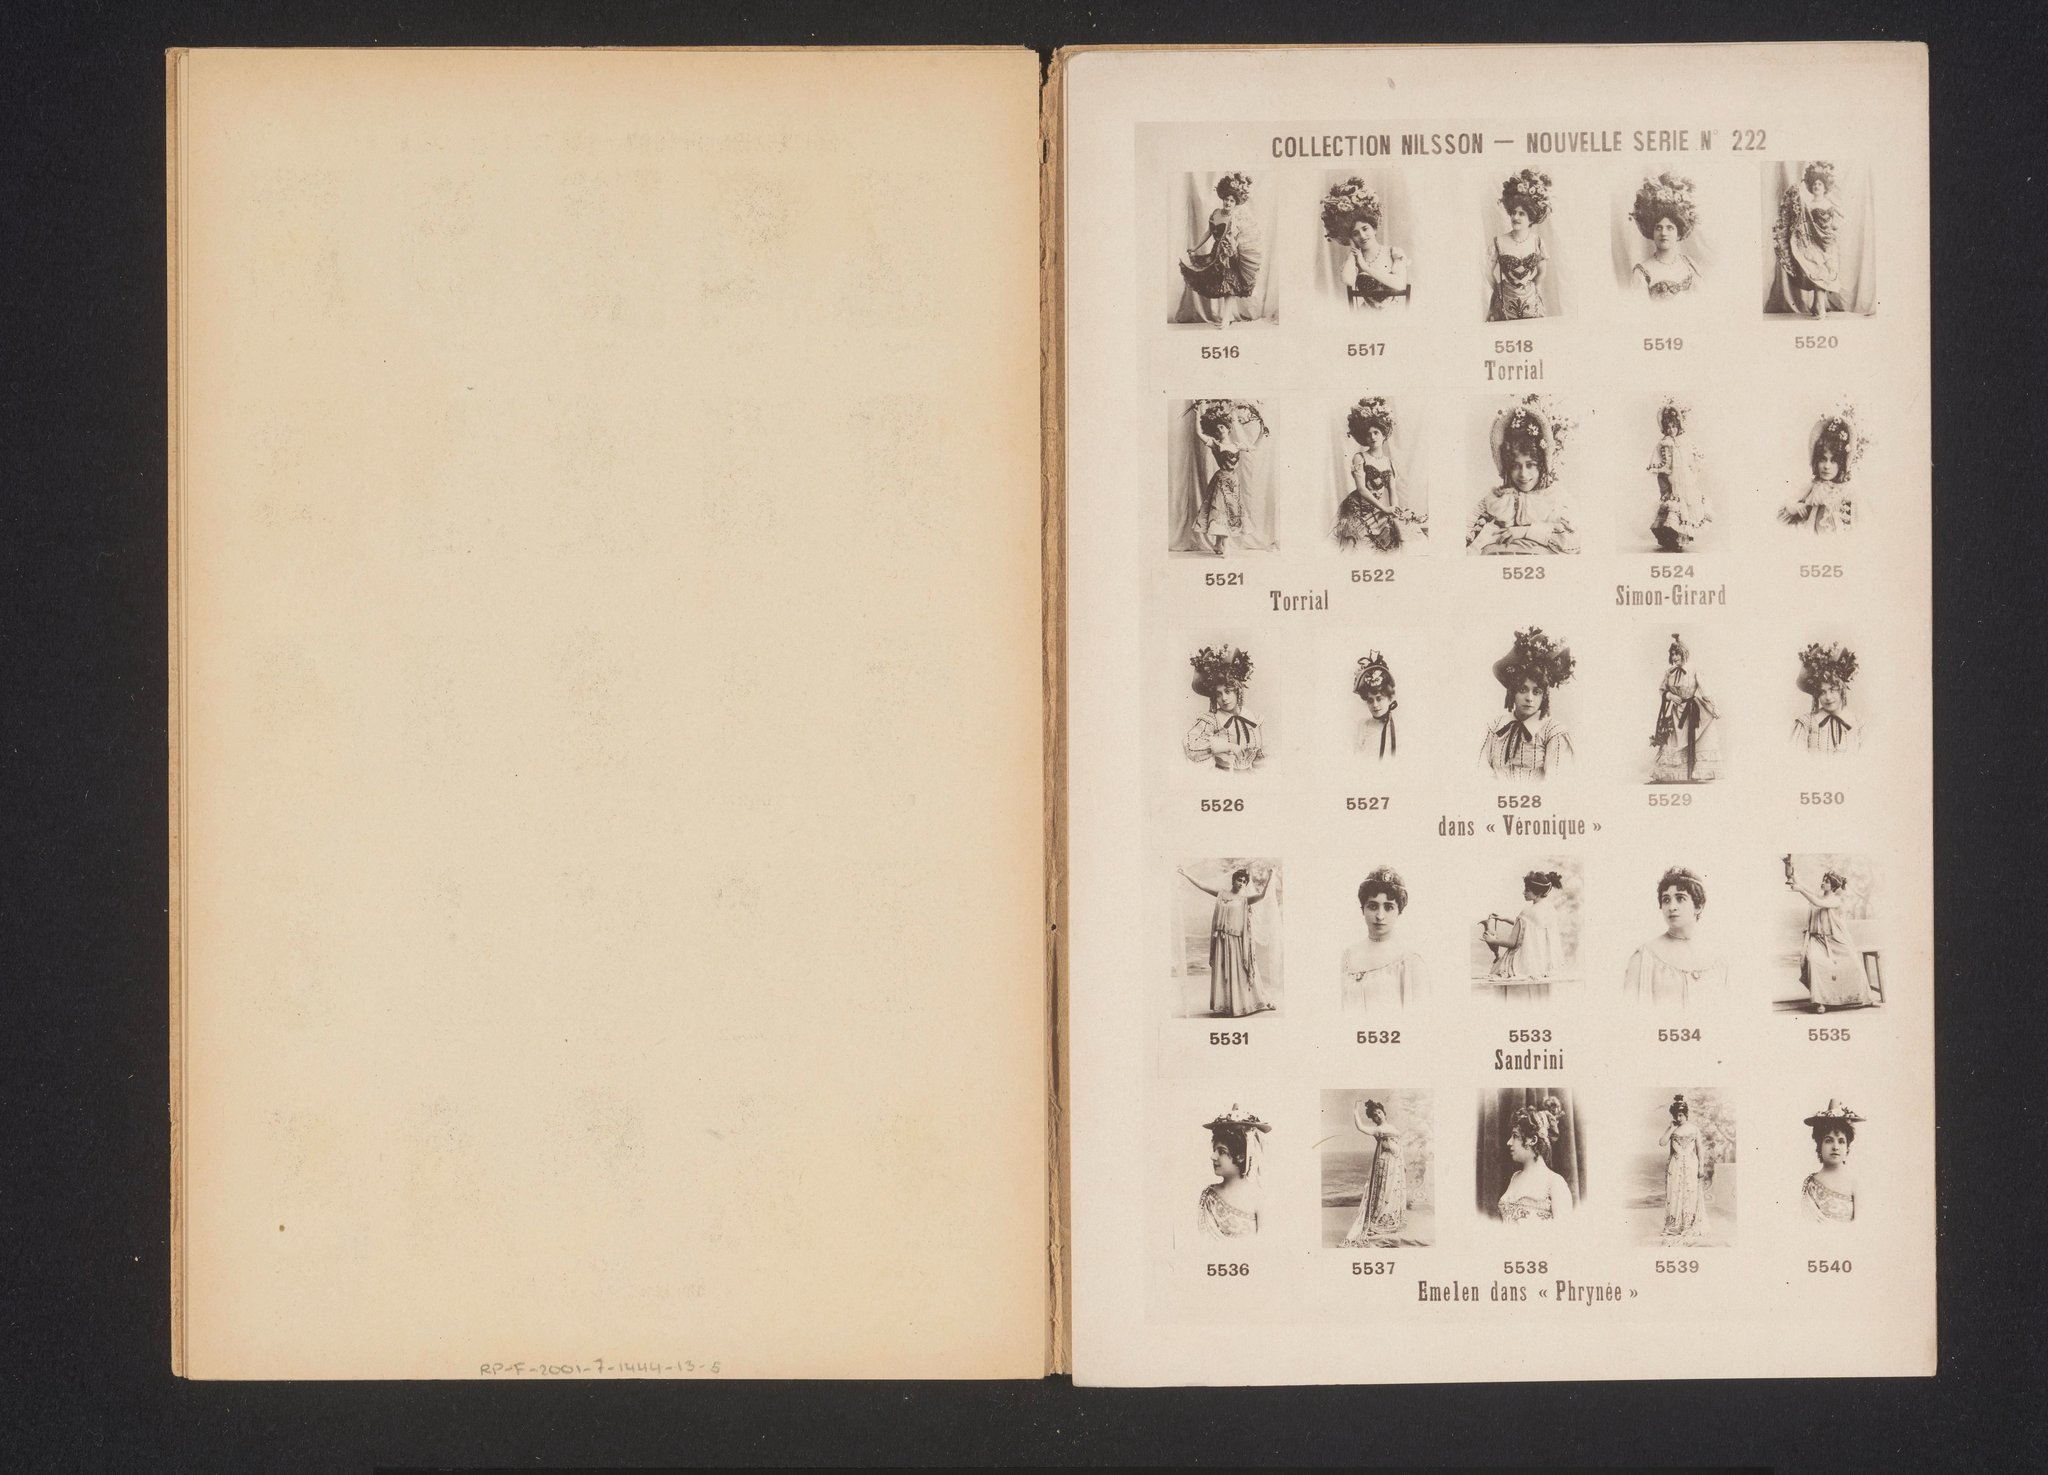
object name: photomechanical print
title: 25 portretten van Torrial, Simon-Girard en Sandrini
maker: Anonymous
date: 1894-1899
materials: paper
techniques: photograph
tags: historical persons - bb - woman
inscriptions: inscription: ‘Torrial/ Torrial Simon-Girard/ dans < < Véronique > >/ Sandrini/ Emelen dans < < Phrynée > >’, number: ‘No 222’